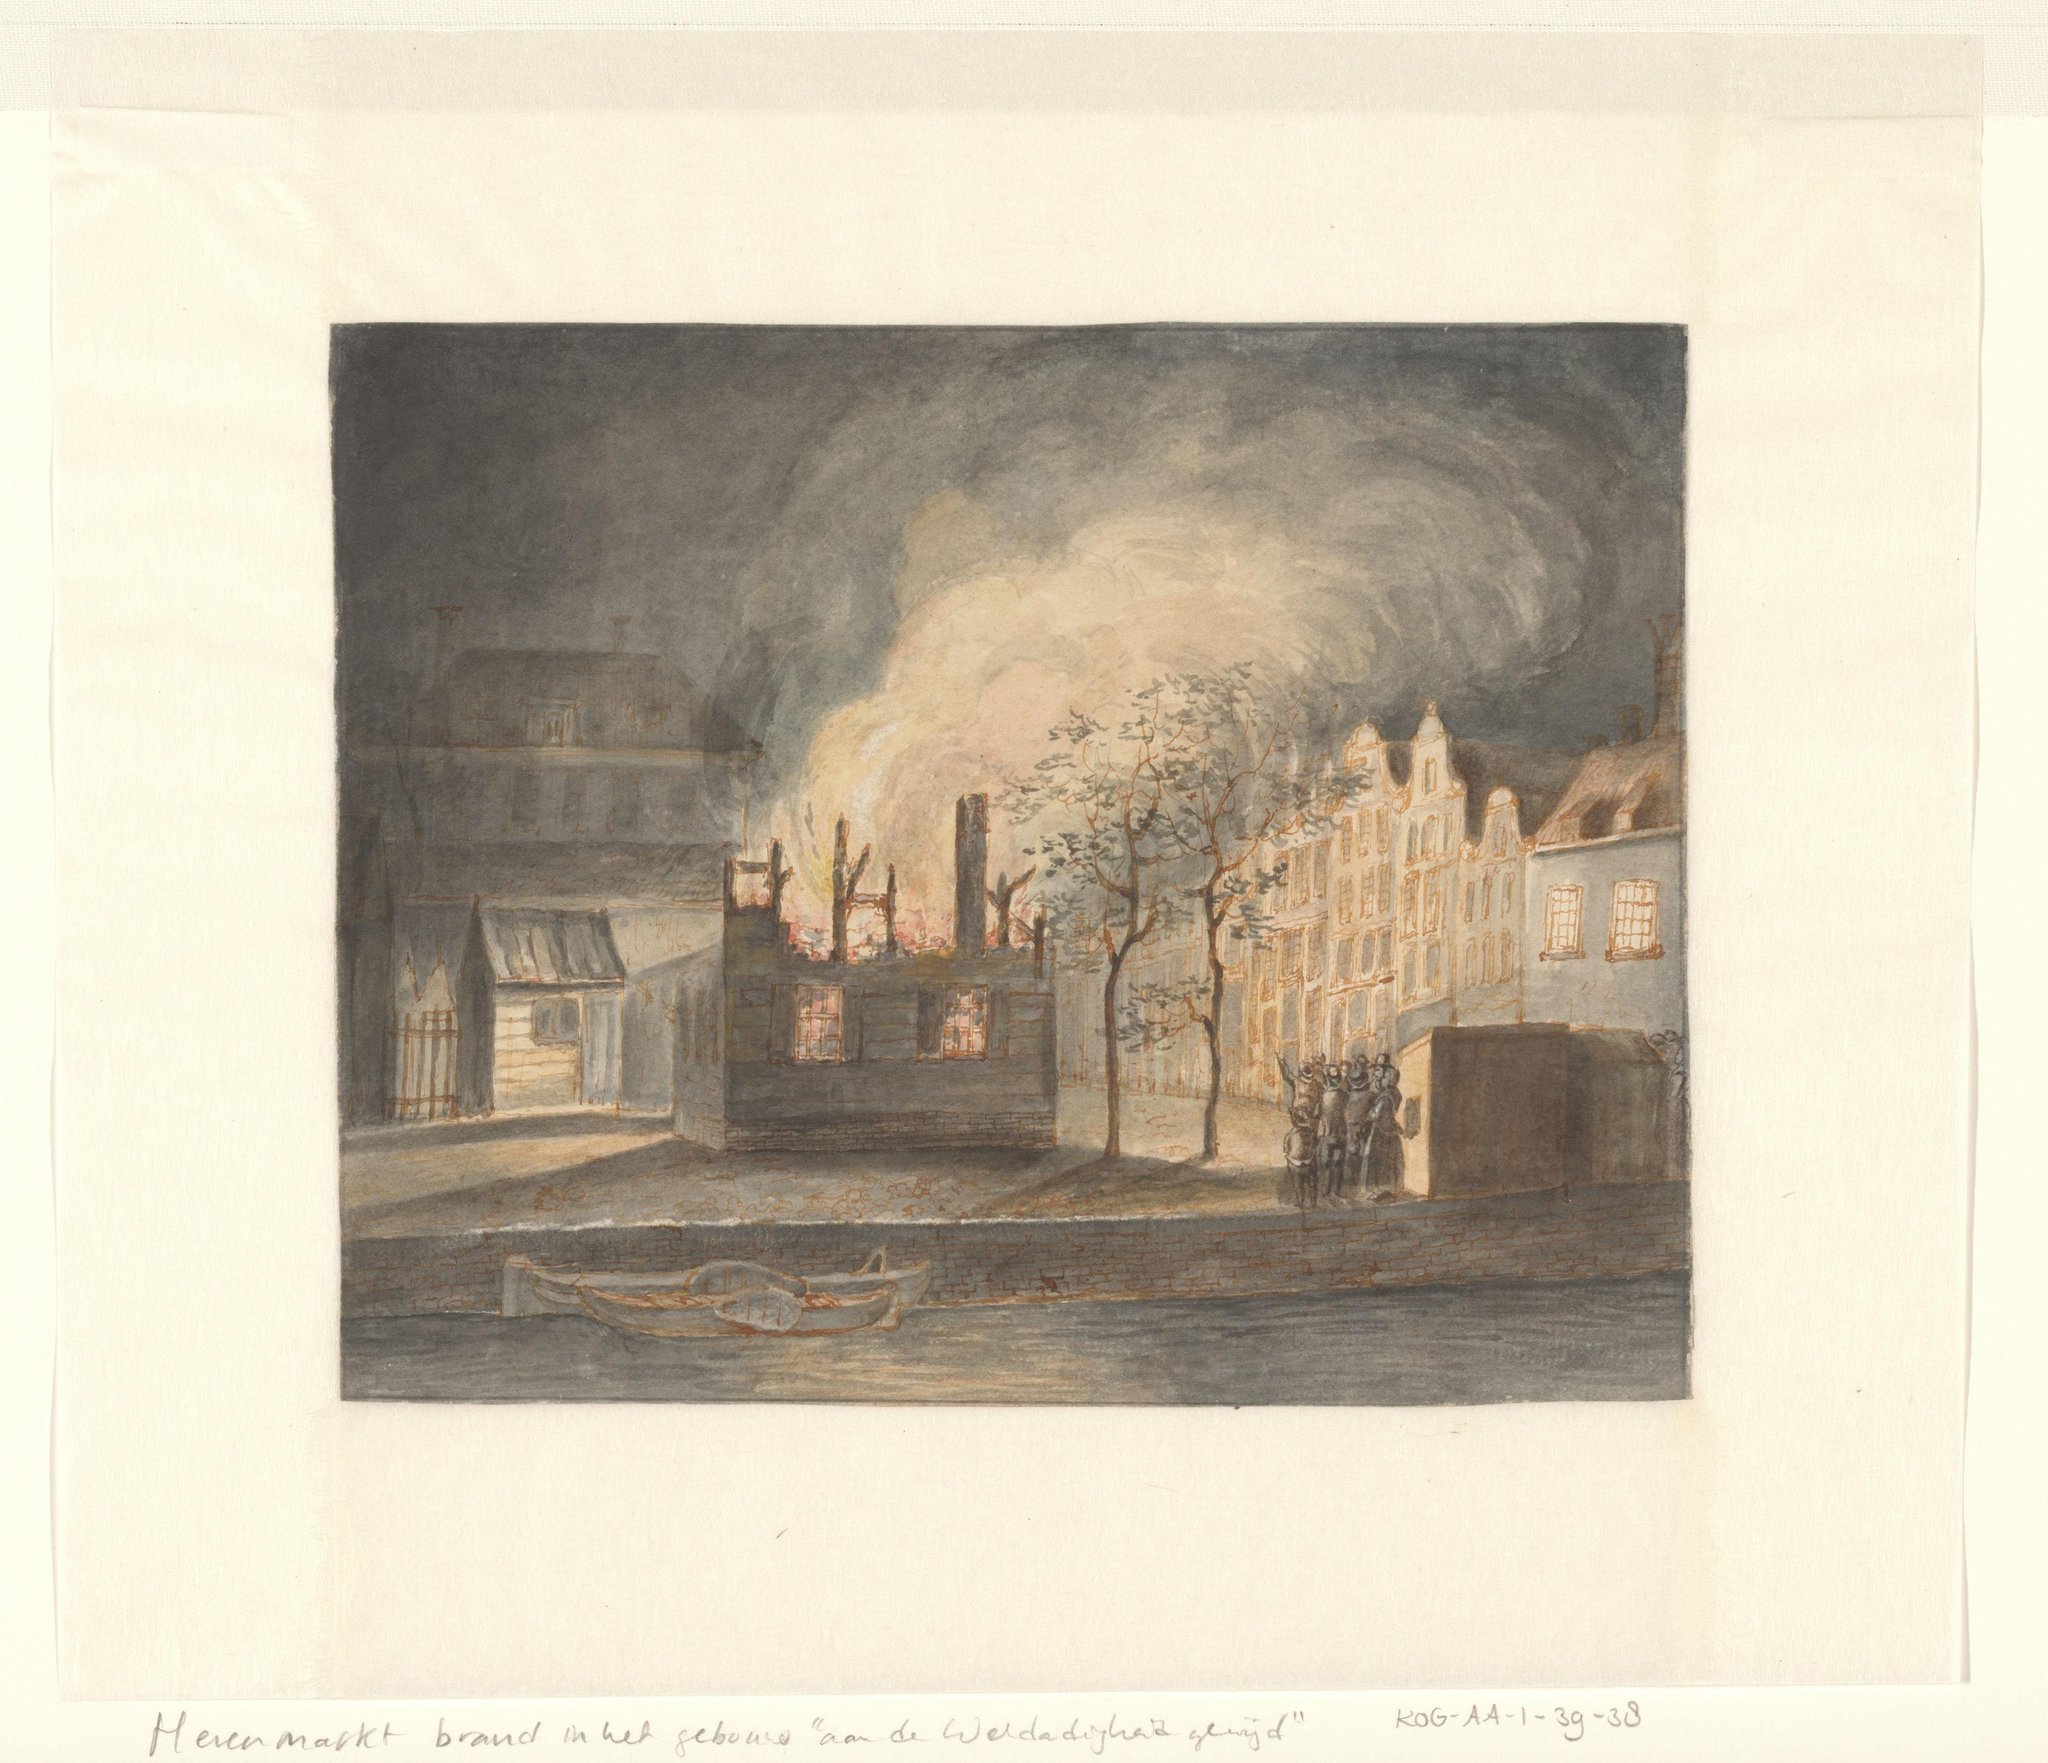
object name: drawing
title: Gezicht op de brand in de Soeploods op de Herenmarkt van 3 juli 1835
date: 1835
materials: paint, ink, paper, watercolor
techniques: brush, pen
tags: on fire, ablaze, city-view in general; 'veduta', shed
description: Onderwerpsrubriek binnen de Atlas Amsterdam: Maatschappij van Weldadigheid - Soeploods op Heerengracht.